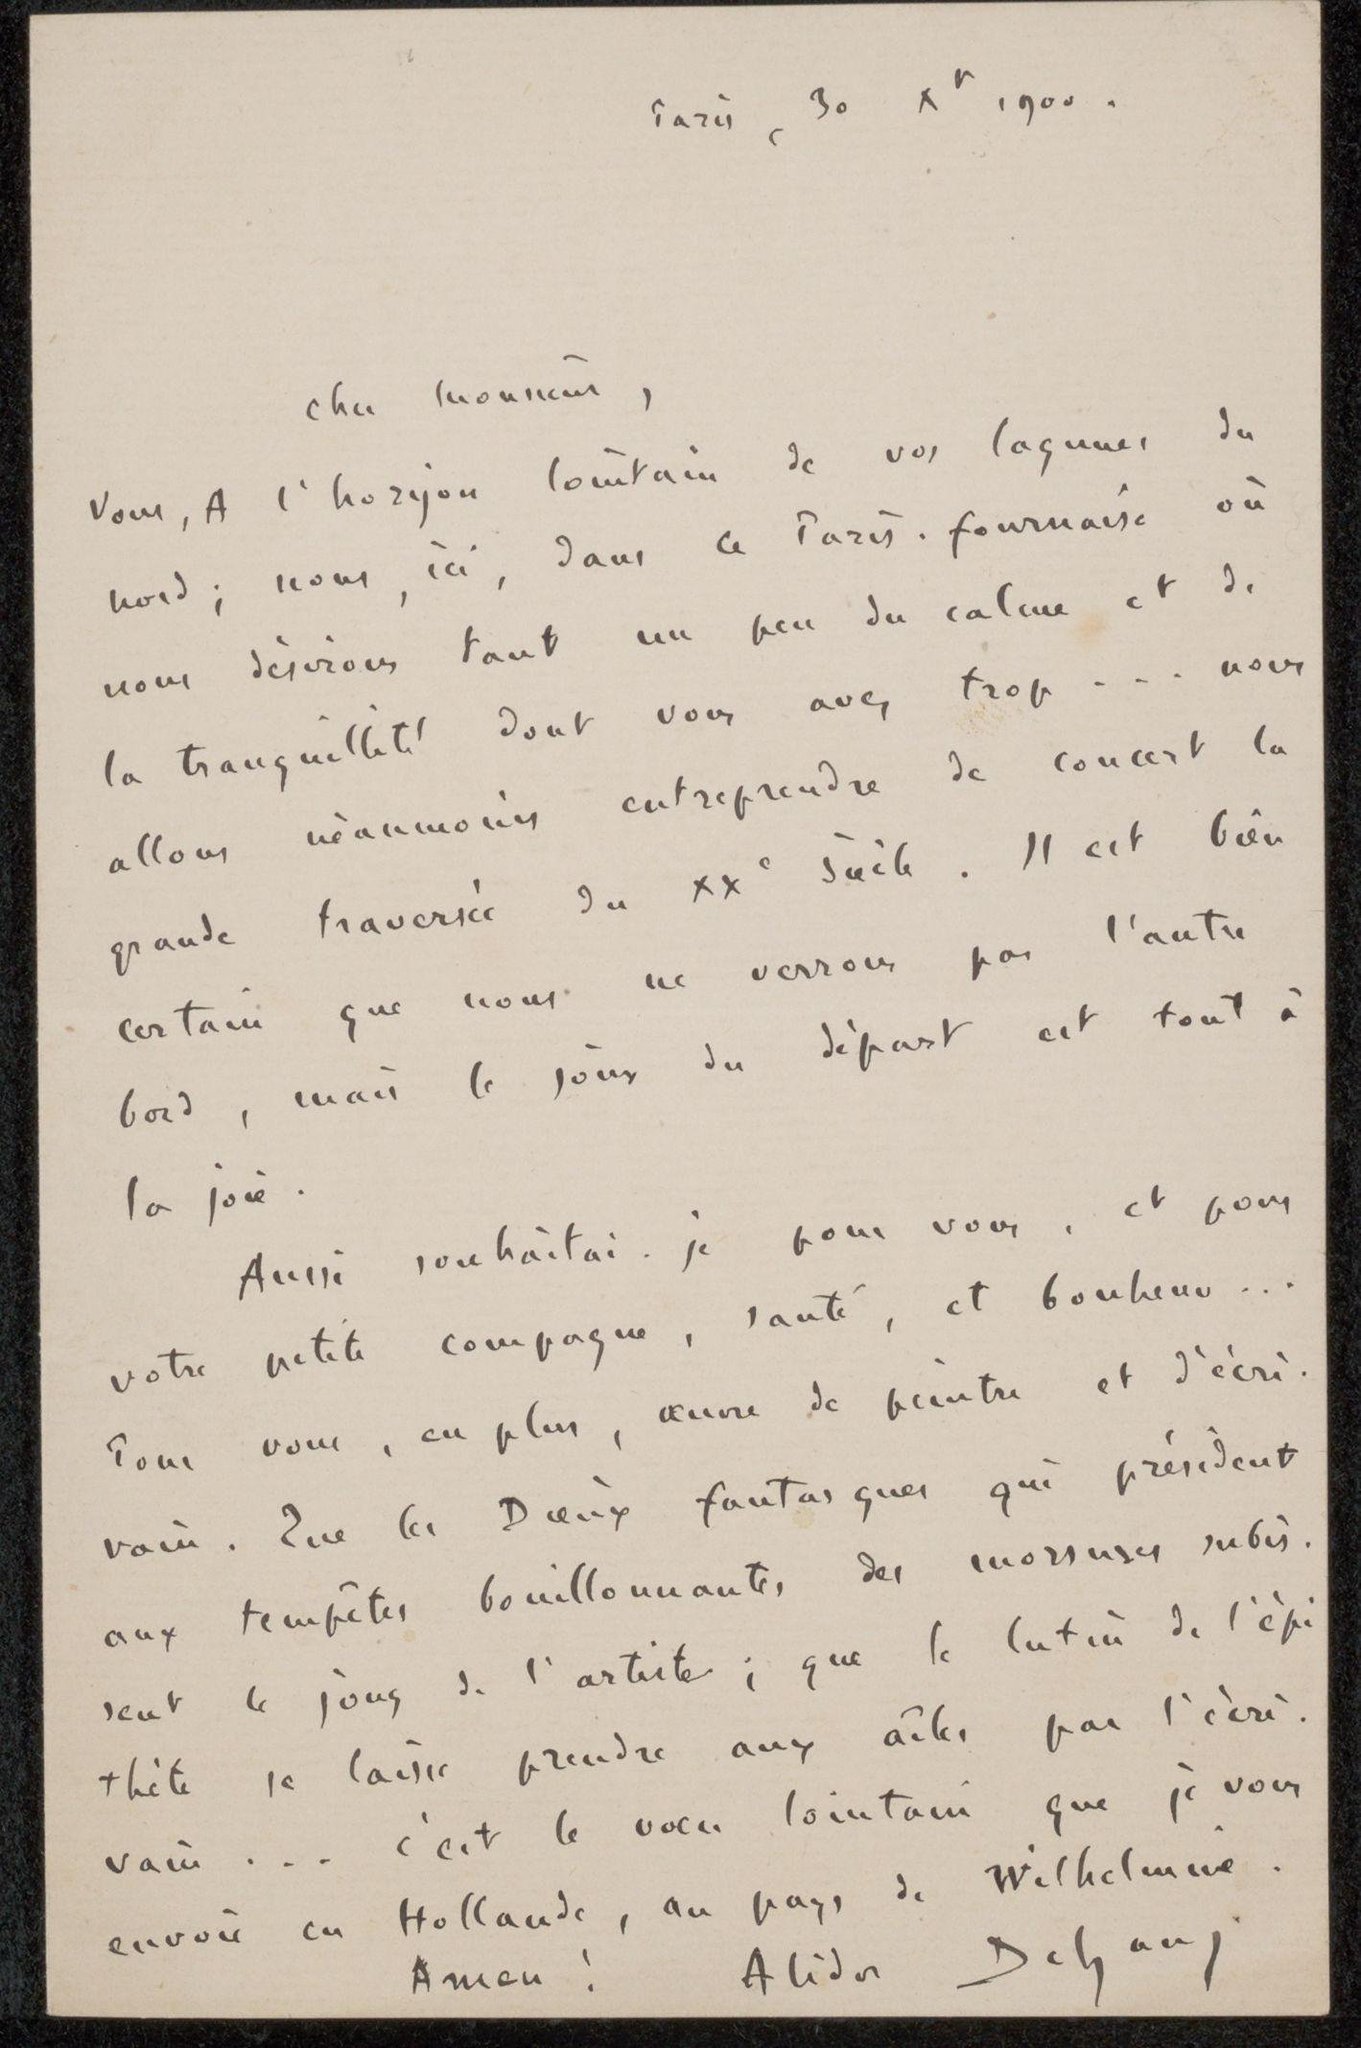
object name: letter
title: Brief aan Philip Zilcken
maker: alidor delzant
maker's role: advocaat, auteur, kunstverzamelaar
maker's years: 1848-1905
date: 1900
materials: ink, paper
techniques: pen, writing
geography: théâtre des folies-marigny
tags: the hague, painter, draughtsman, philip zilcken, paris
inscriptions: watermark, collector's mark: ‘RPK’